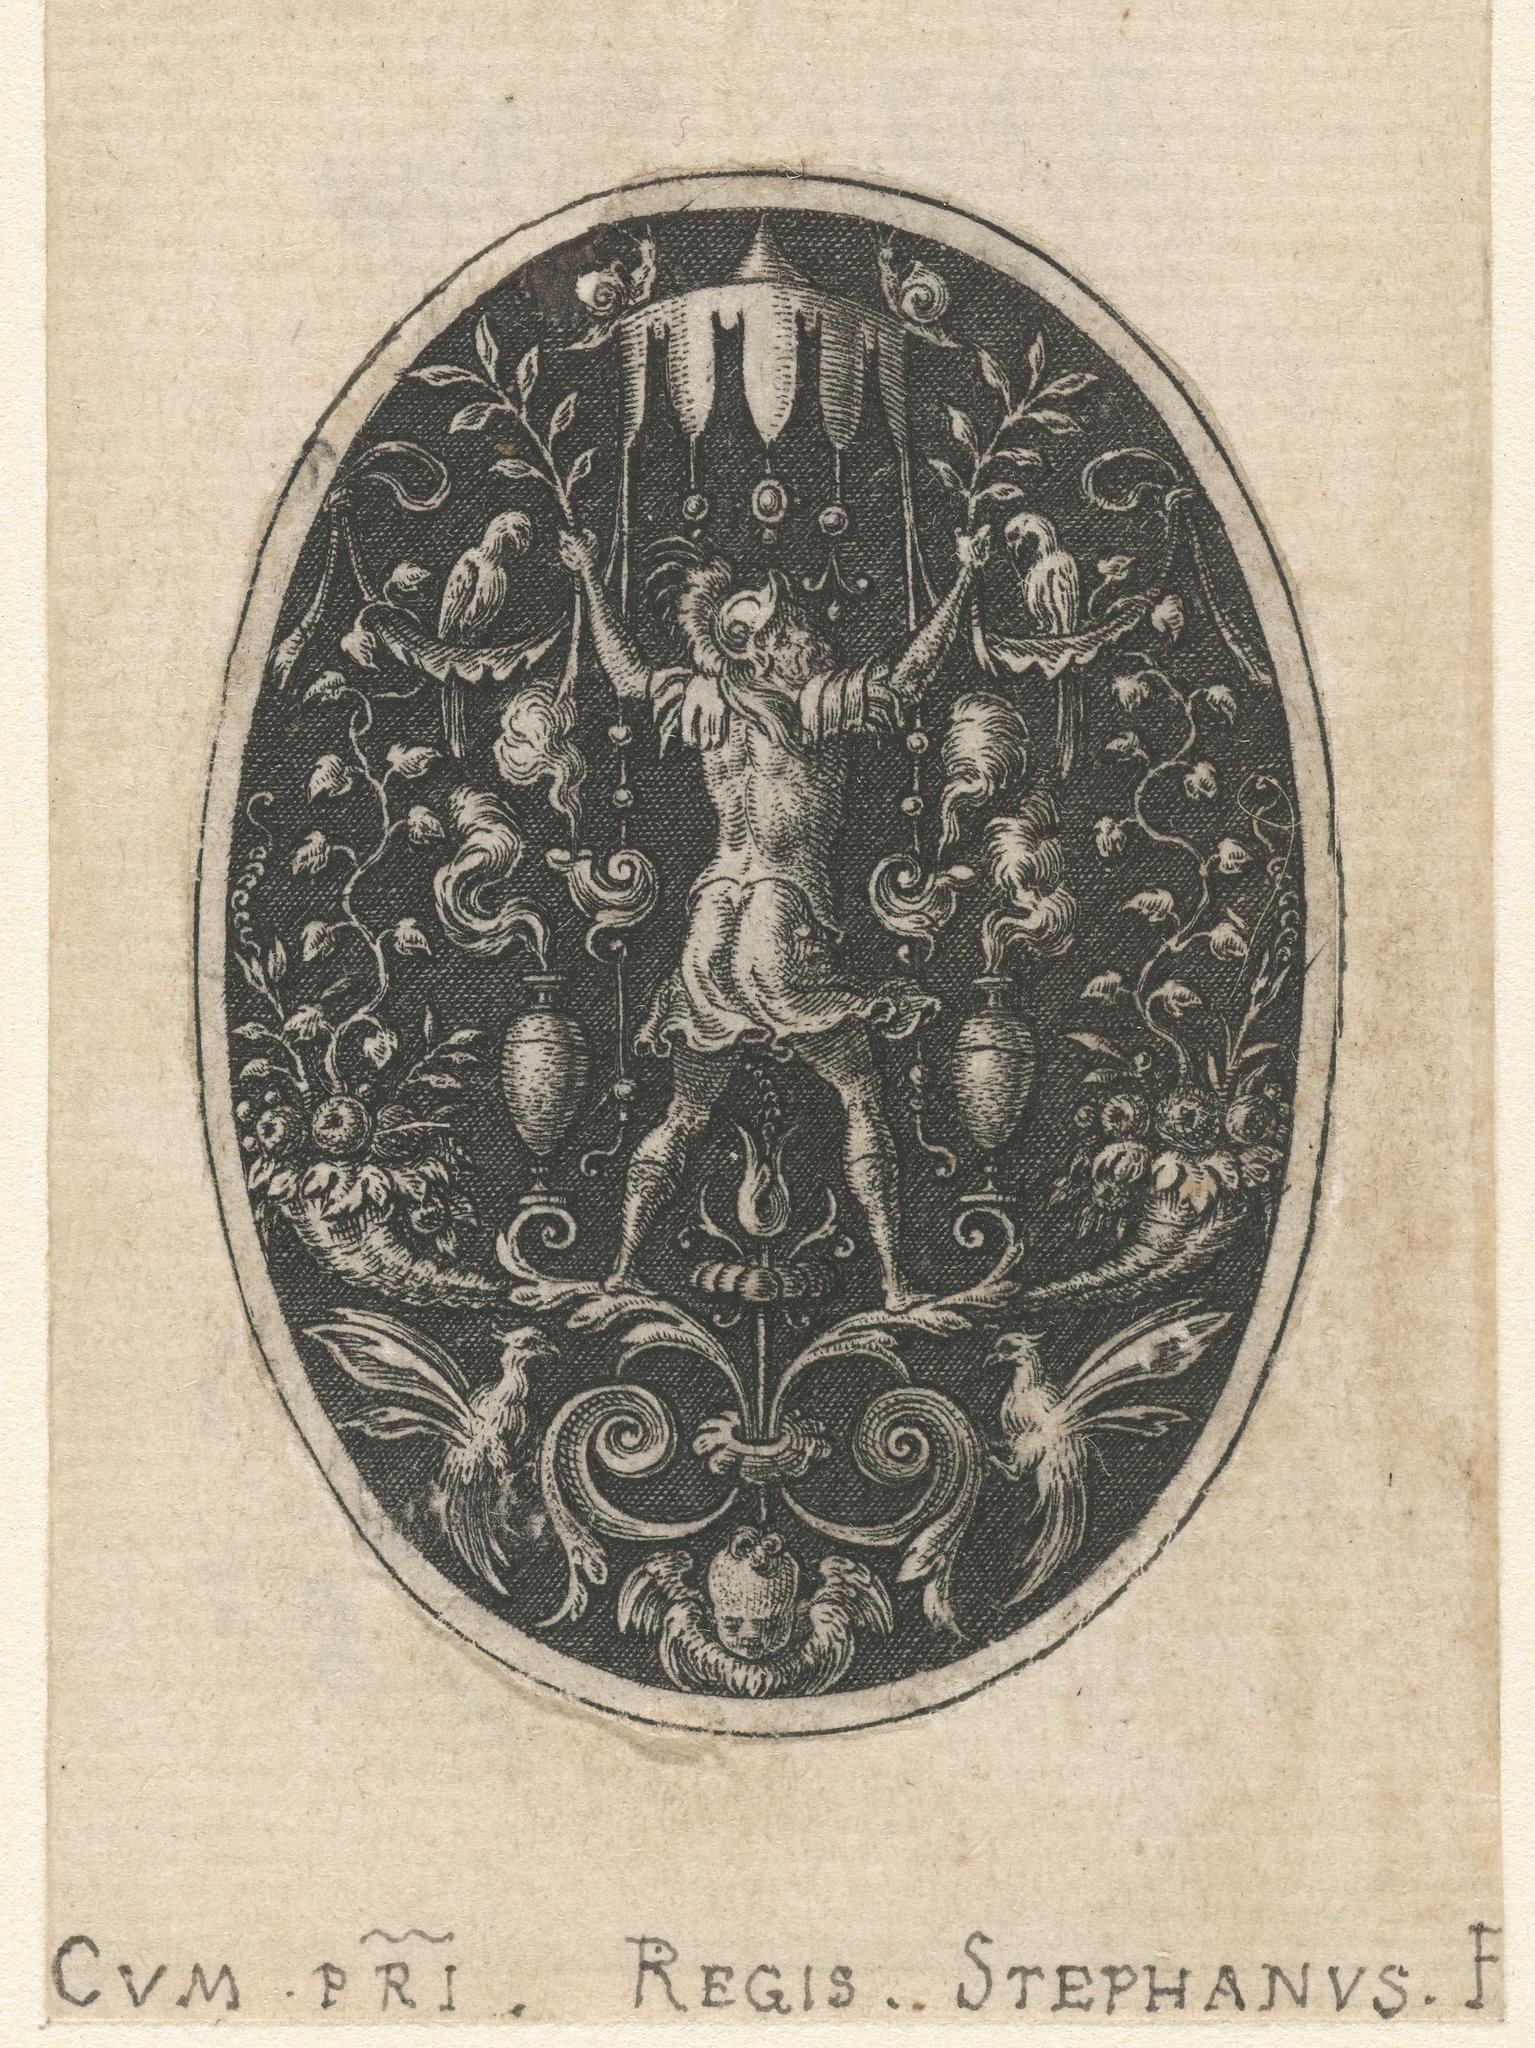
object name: print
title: Mars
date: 1528-1583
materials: paper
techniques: engraving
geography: france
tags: (story of) mars (ares)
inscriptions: inscription: ‘CVM. PRI. REGIS.. STEPHANVS.F’